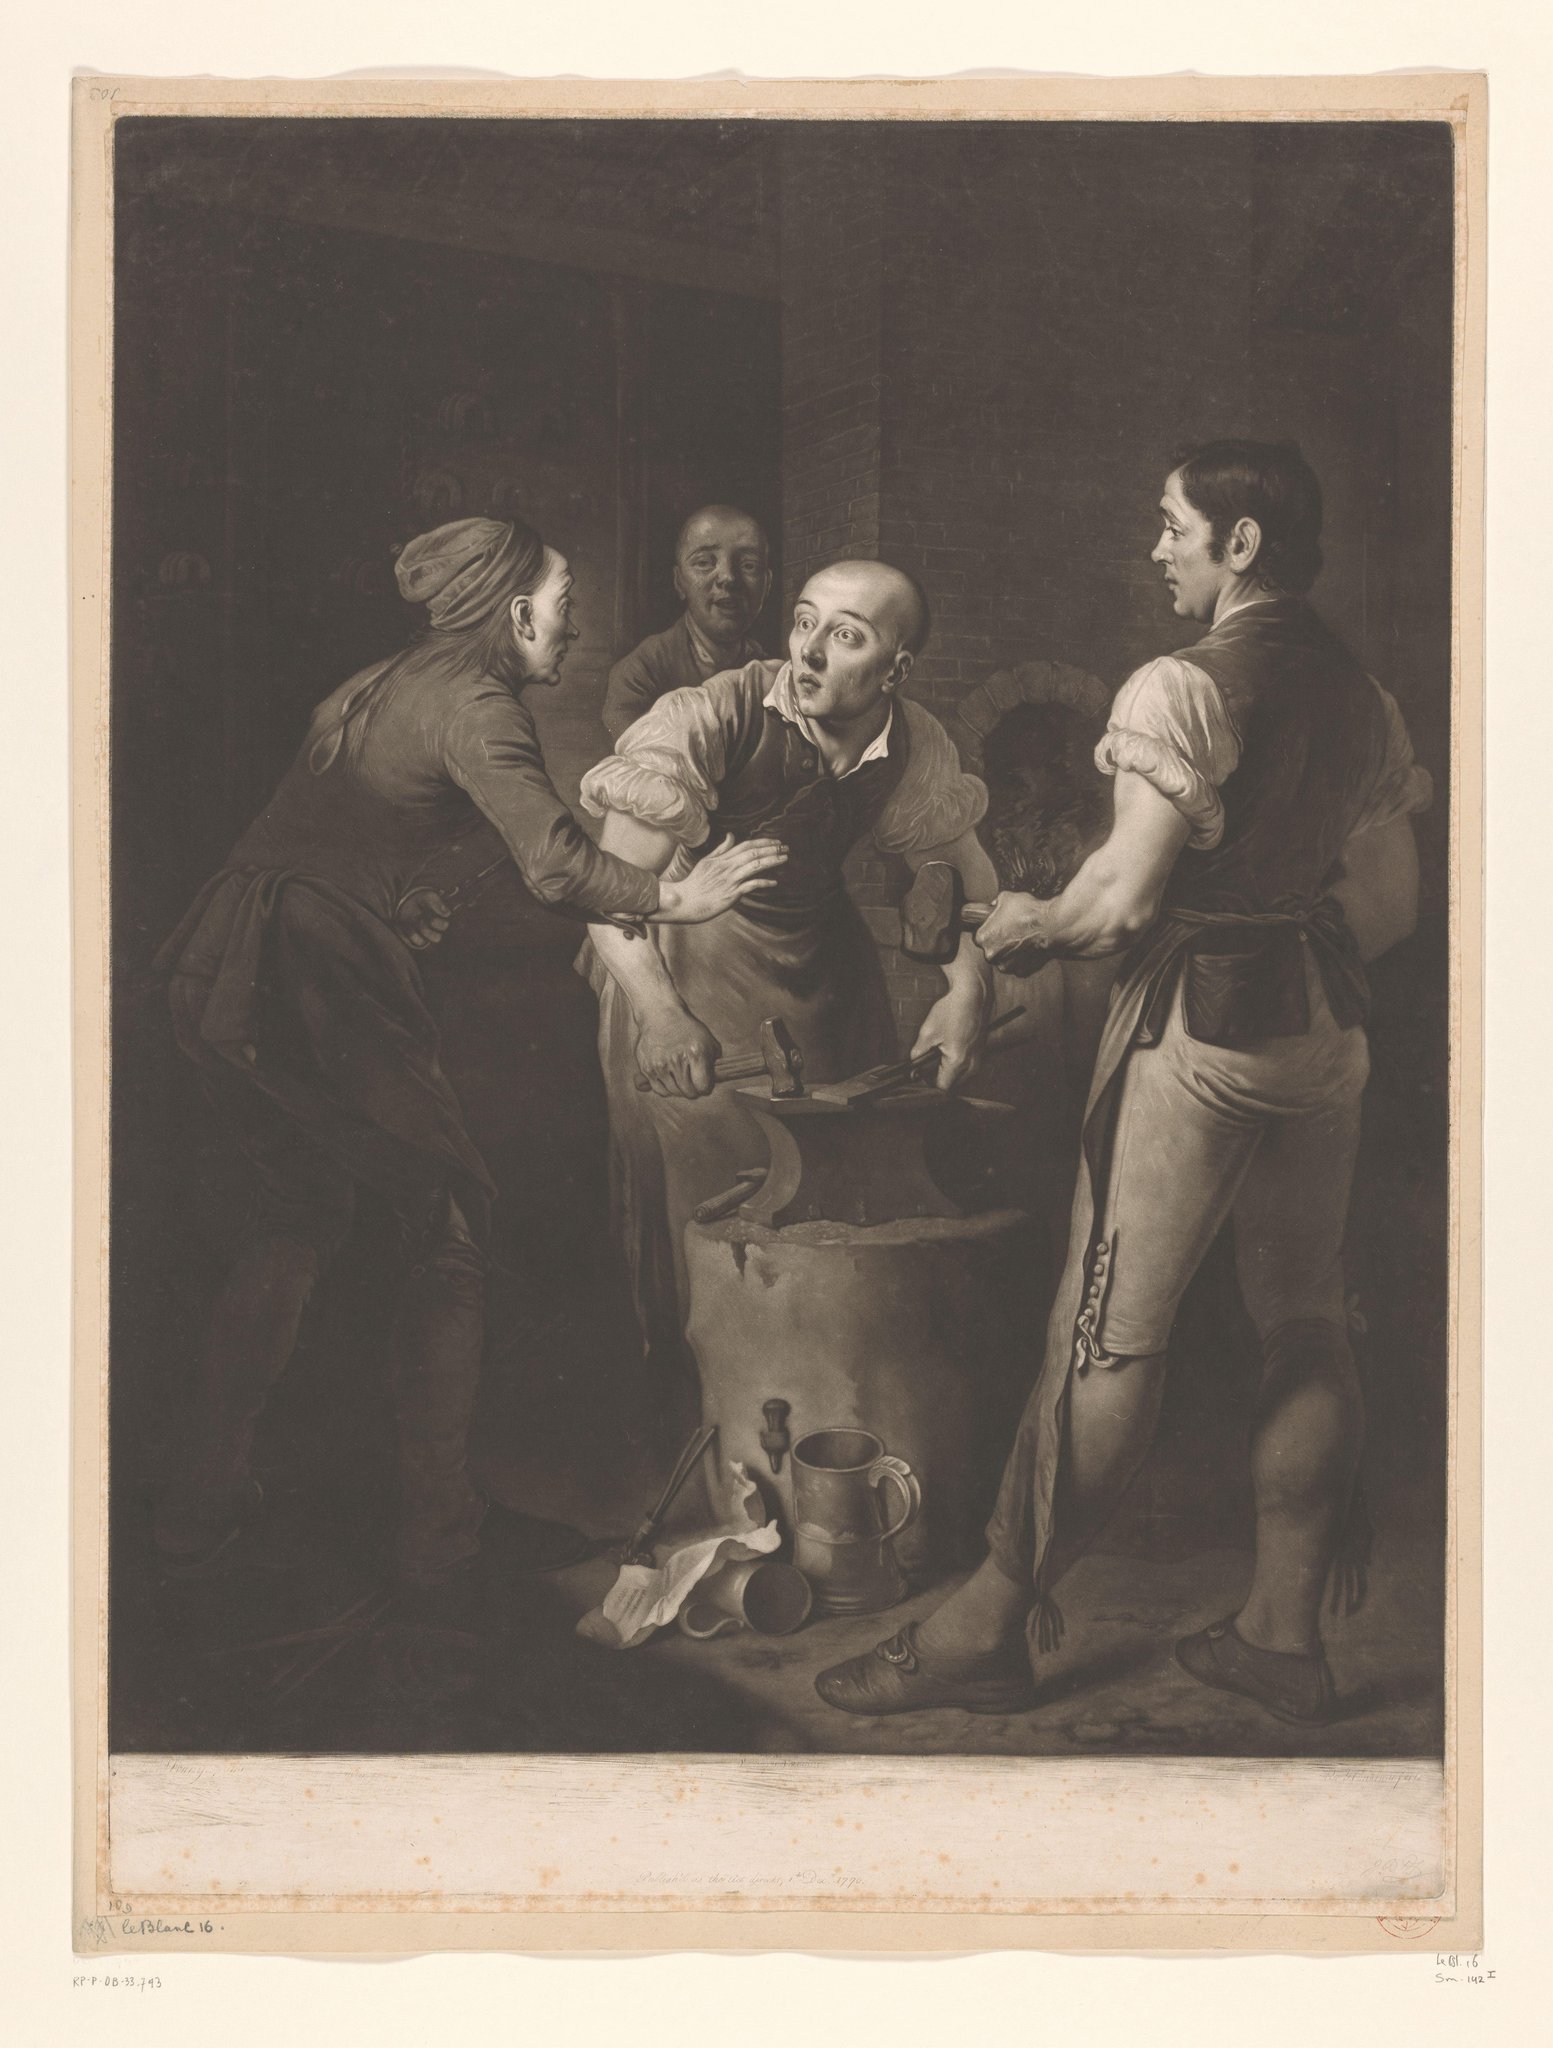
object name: print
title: Newsmongers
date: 1770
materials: paper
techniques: mezzotint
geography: london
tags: slander, smith, blacksmith, forging (industrial process)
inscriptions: collector's mark: Lugt 240